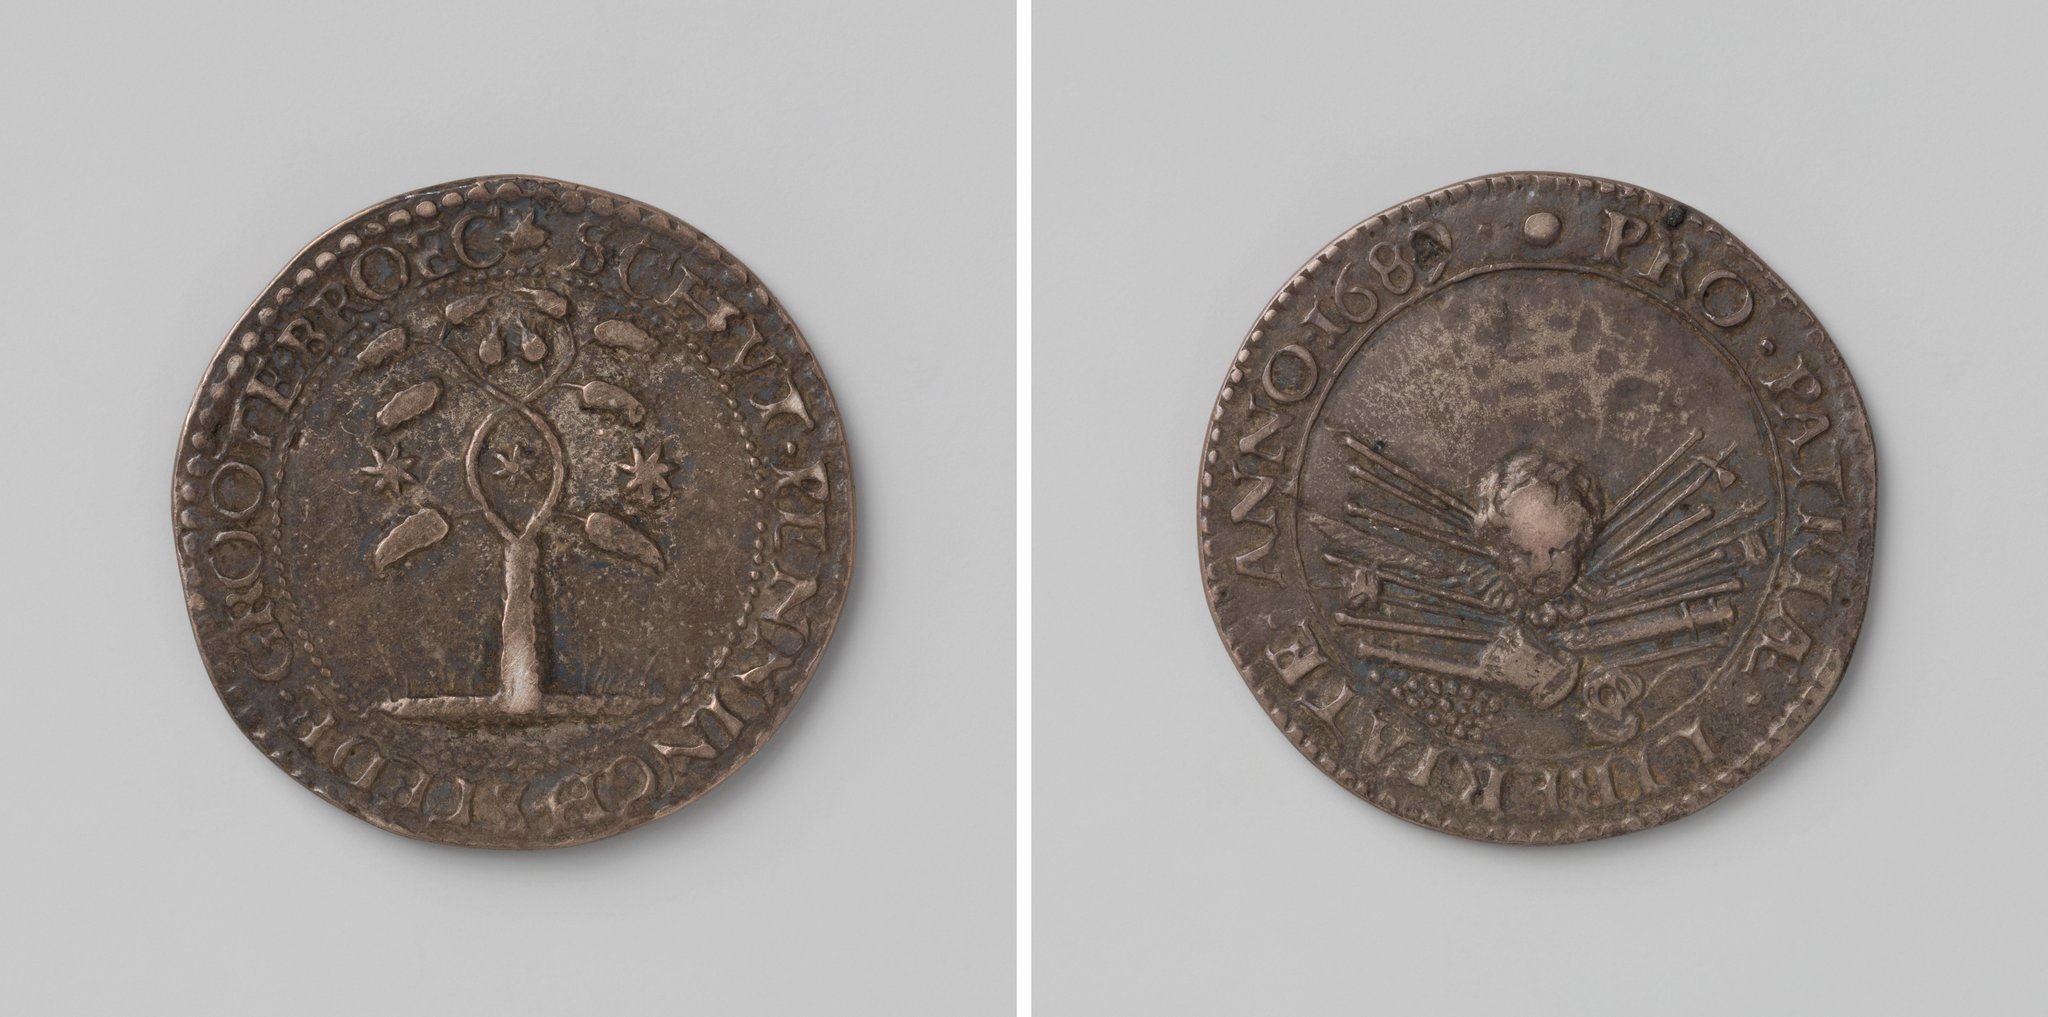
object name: marksman medal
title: Schutterij van Grootebroek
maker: Anonymous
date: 1689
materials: silver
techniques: striking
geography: grootebroek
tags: grootebroek